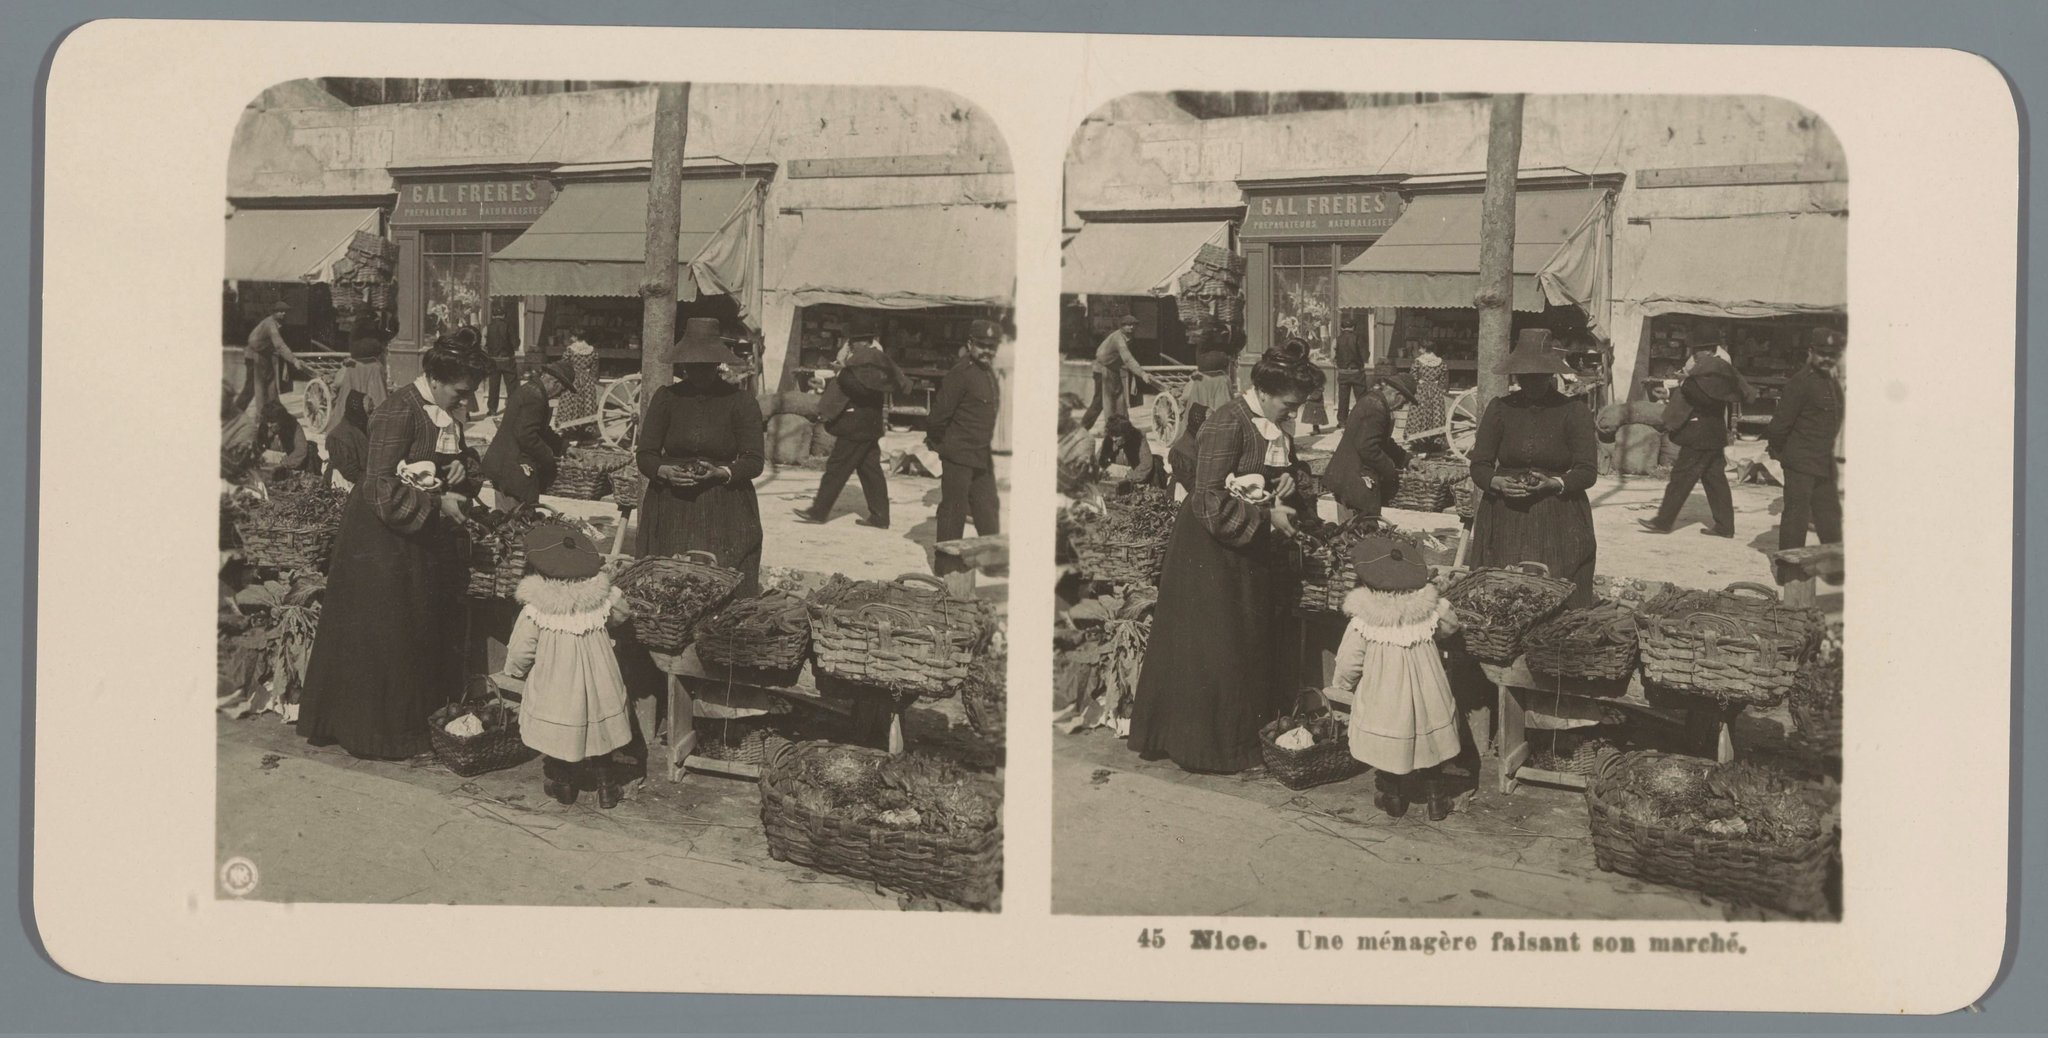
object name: stereograph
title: Nice. Une ménagère faisant son marché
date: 1904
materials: cardboard, photographic support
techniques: gelatin silver print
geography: nice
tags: going to the market, market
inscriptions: number: ‘45’, inscription: ‘NPG’